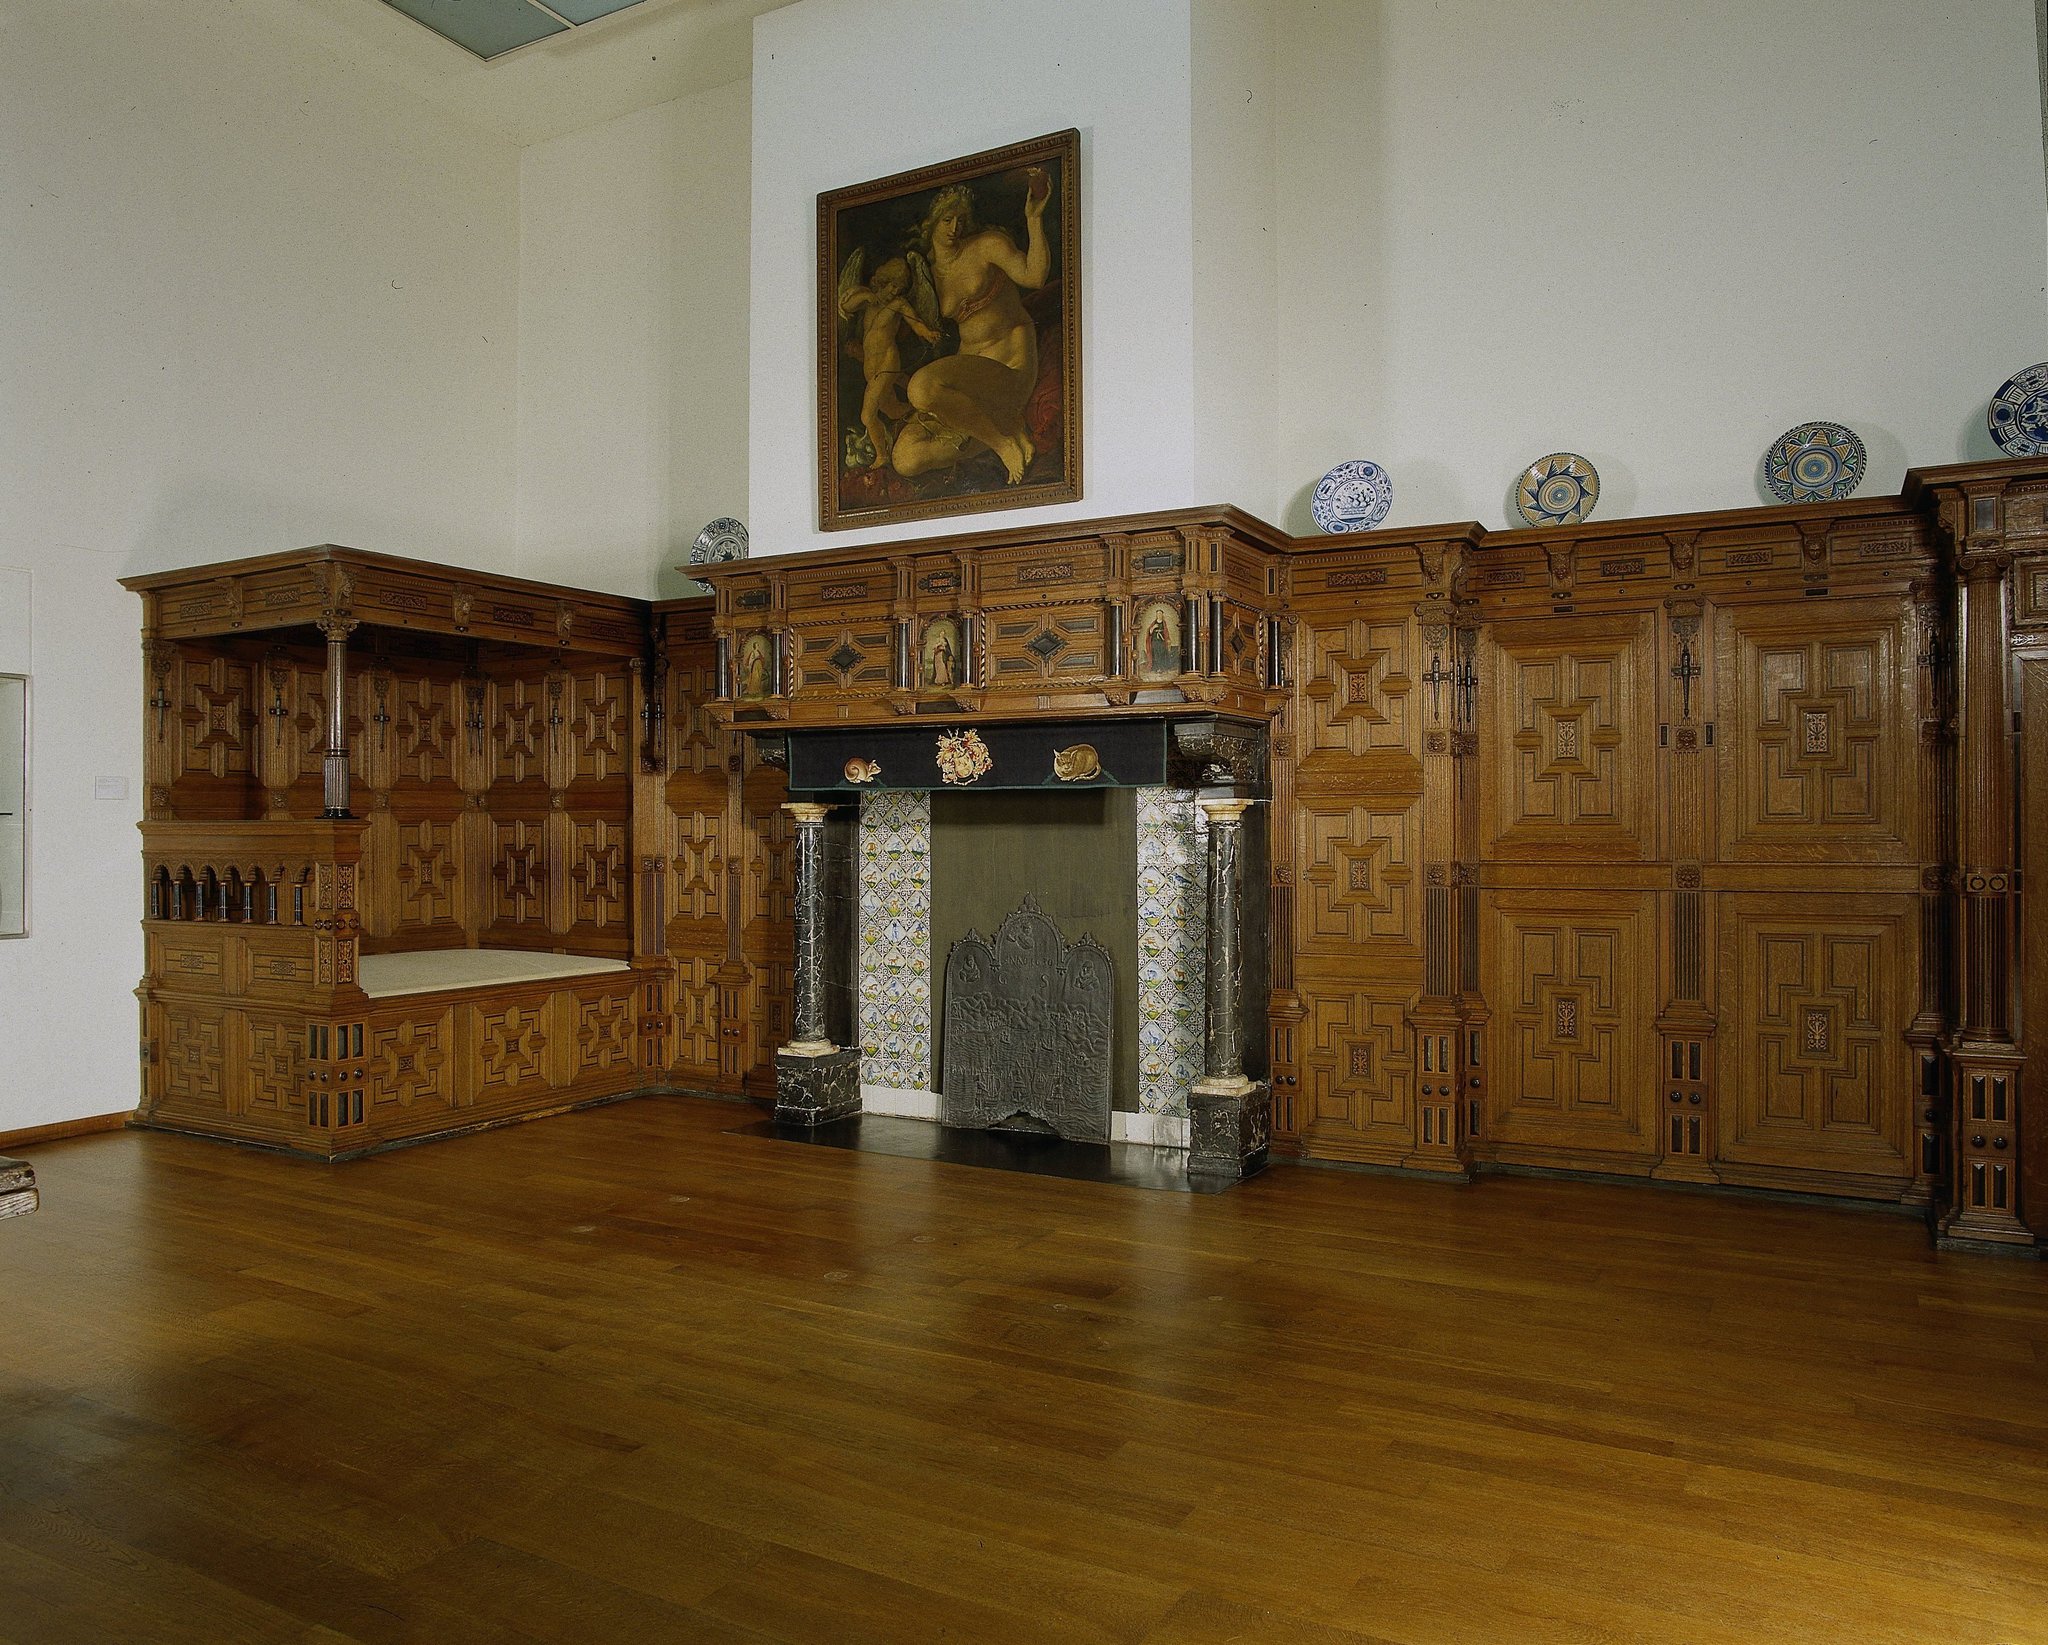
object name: schoorsteenfries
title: Schoorsteen van kunstmarmer, onderdeel van betimmering 1626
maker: Anonymous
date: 1626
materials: marble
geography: northern netherlands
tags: dordrecht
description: De schoorsteen heeft een witgeaderde, zwart kunstmarmeren stoel met vrijstaande Toscaanse kolommen op voetstukken, die voor vlakke pilasters zijn geplaatst en consoles dragen. Basis en kapiteel zijn van bruin geaderd wit marmer. Op de consoles rust de schoorsteenmantel. De fries draagt in het midden en op de hoeken een boogstelling, waarin de figuren van Geloof, Hoop en Liefde zijn geschilderd. De middelste cartouche boven de boogstelling draagt het jaartal 1626.